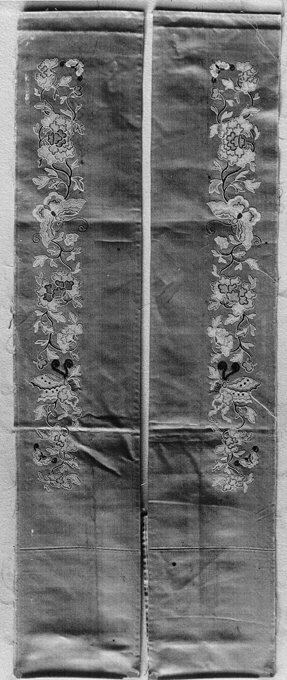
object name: sleeve band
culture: chinese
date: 1801-1900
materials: metal thread, silk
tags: flowers